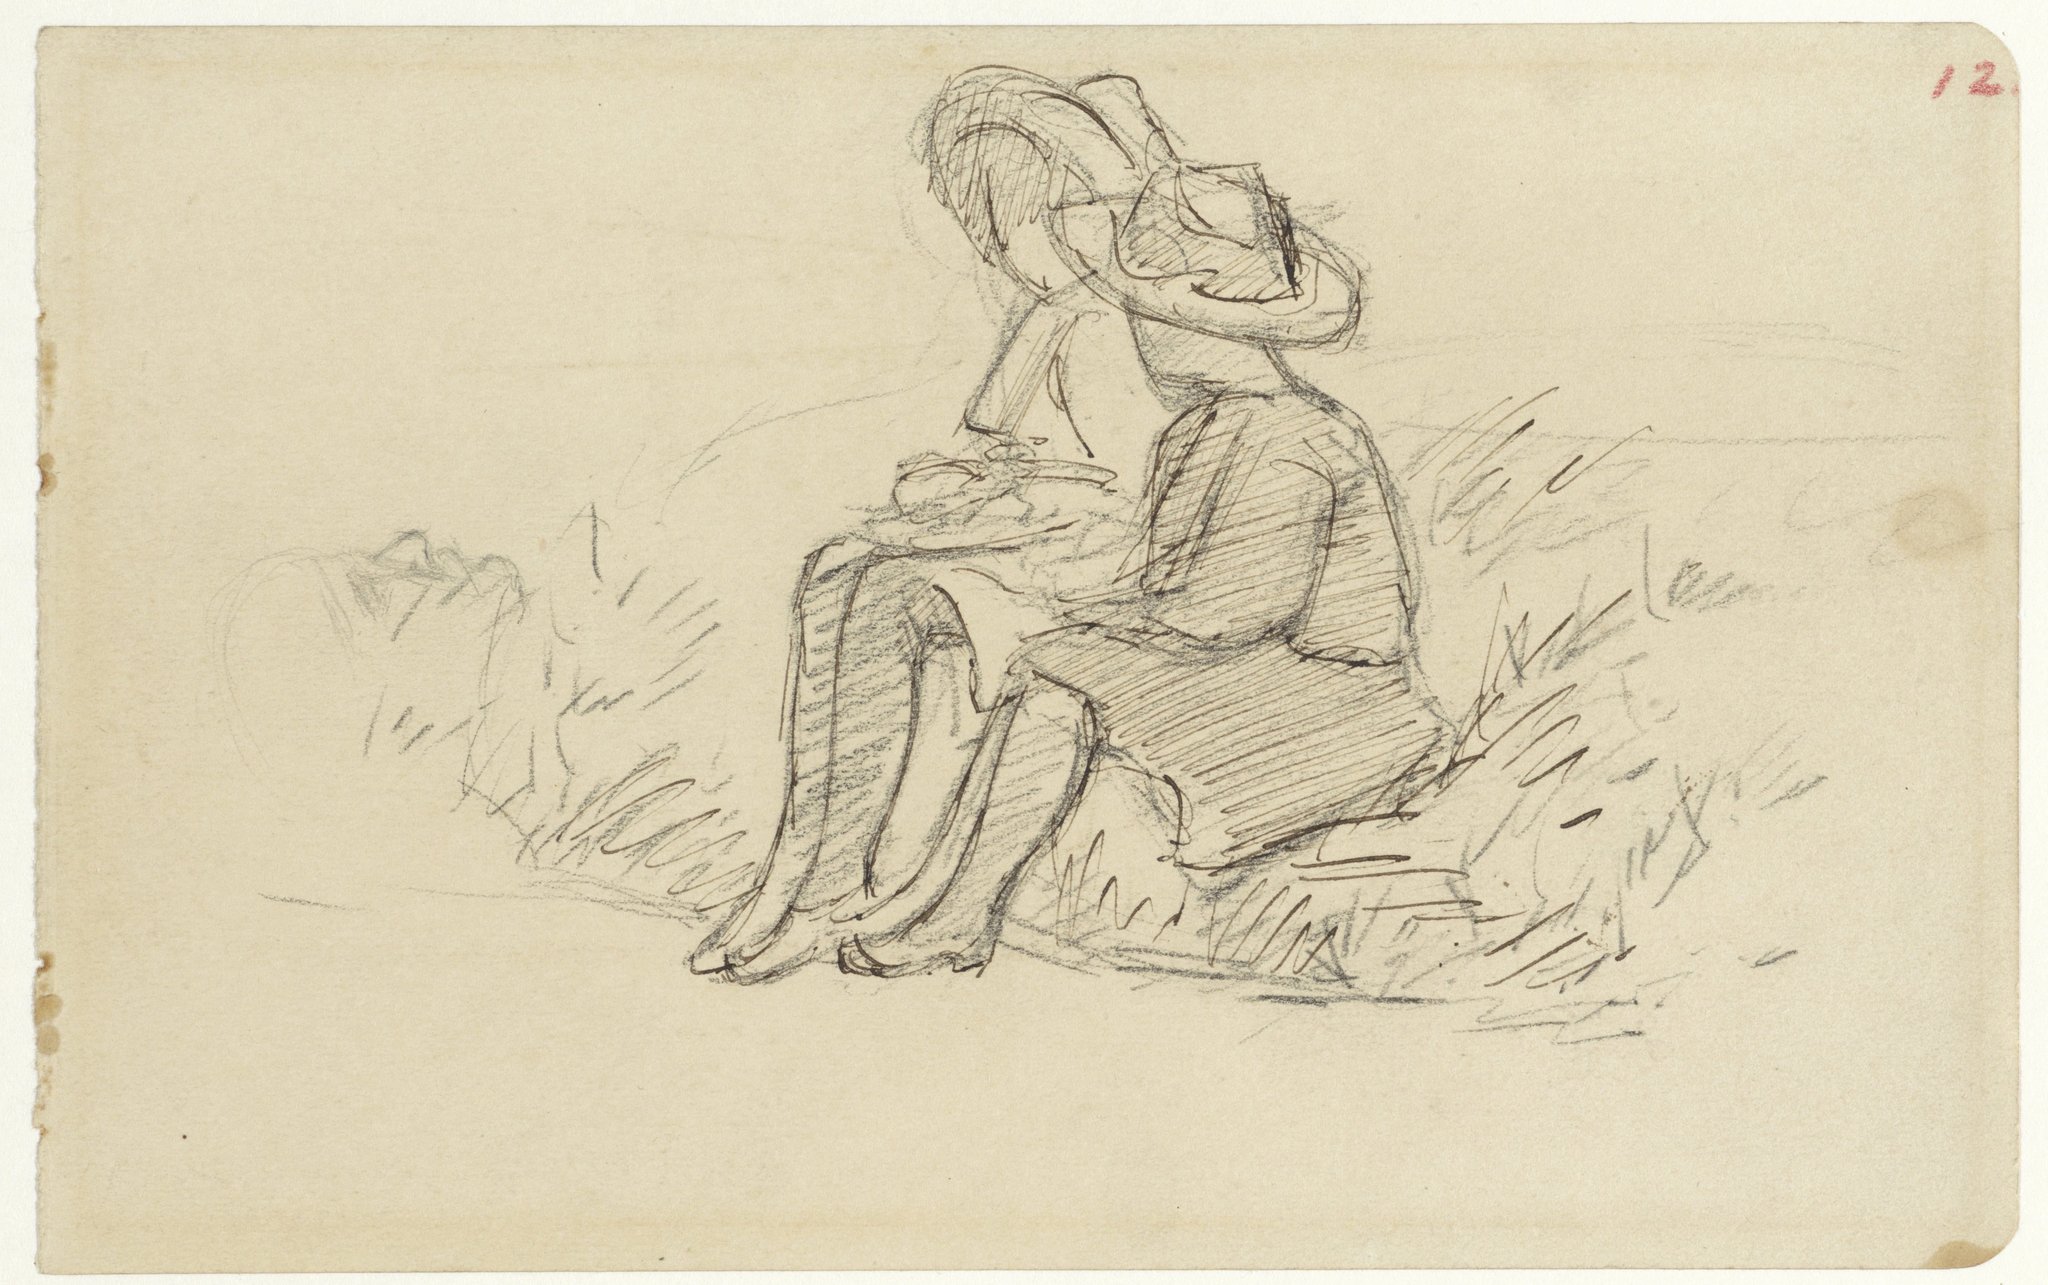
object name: drawing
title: Twee zittende meisjes, buiten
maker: jozef israëls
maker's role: draughtsman, painter, print maker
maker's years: 1824-1911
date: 1834-1911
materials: chalk, ink, paper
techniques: pen